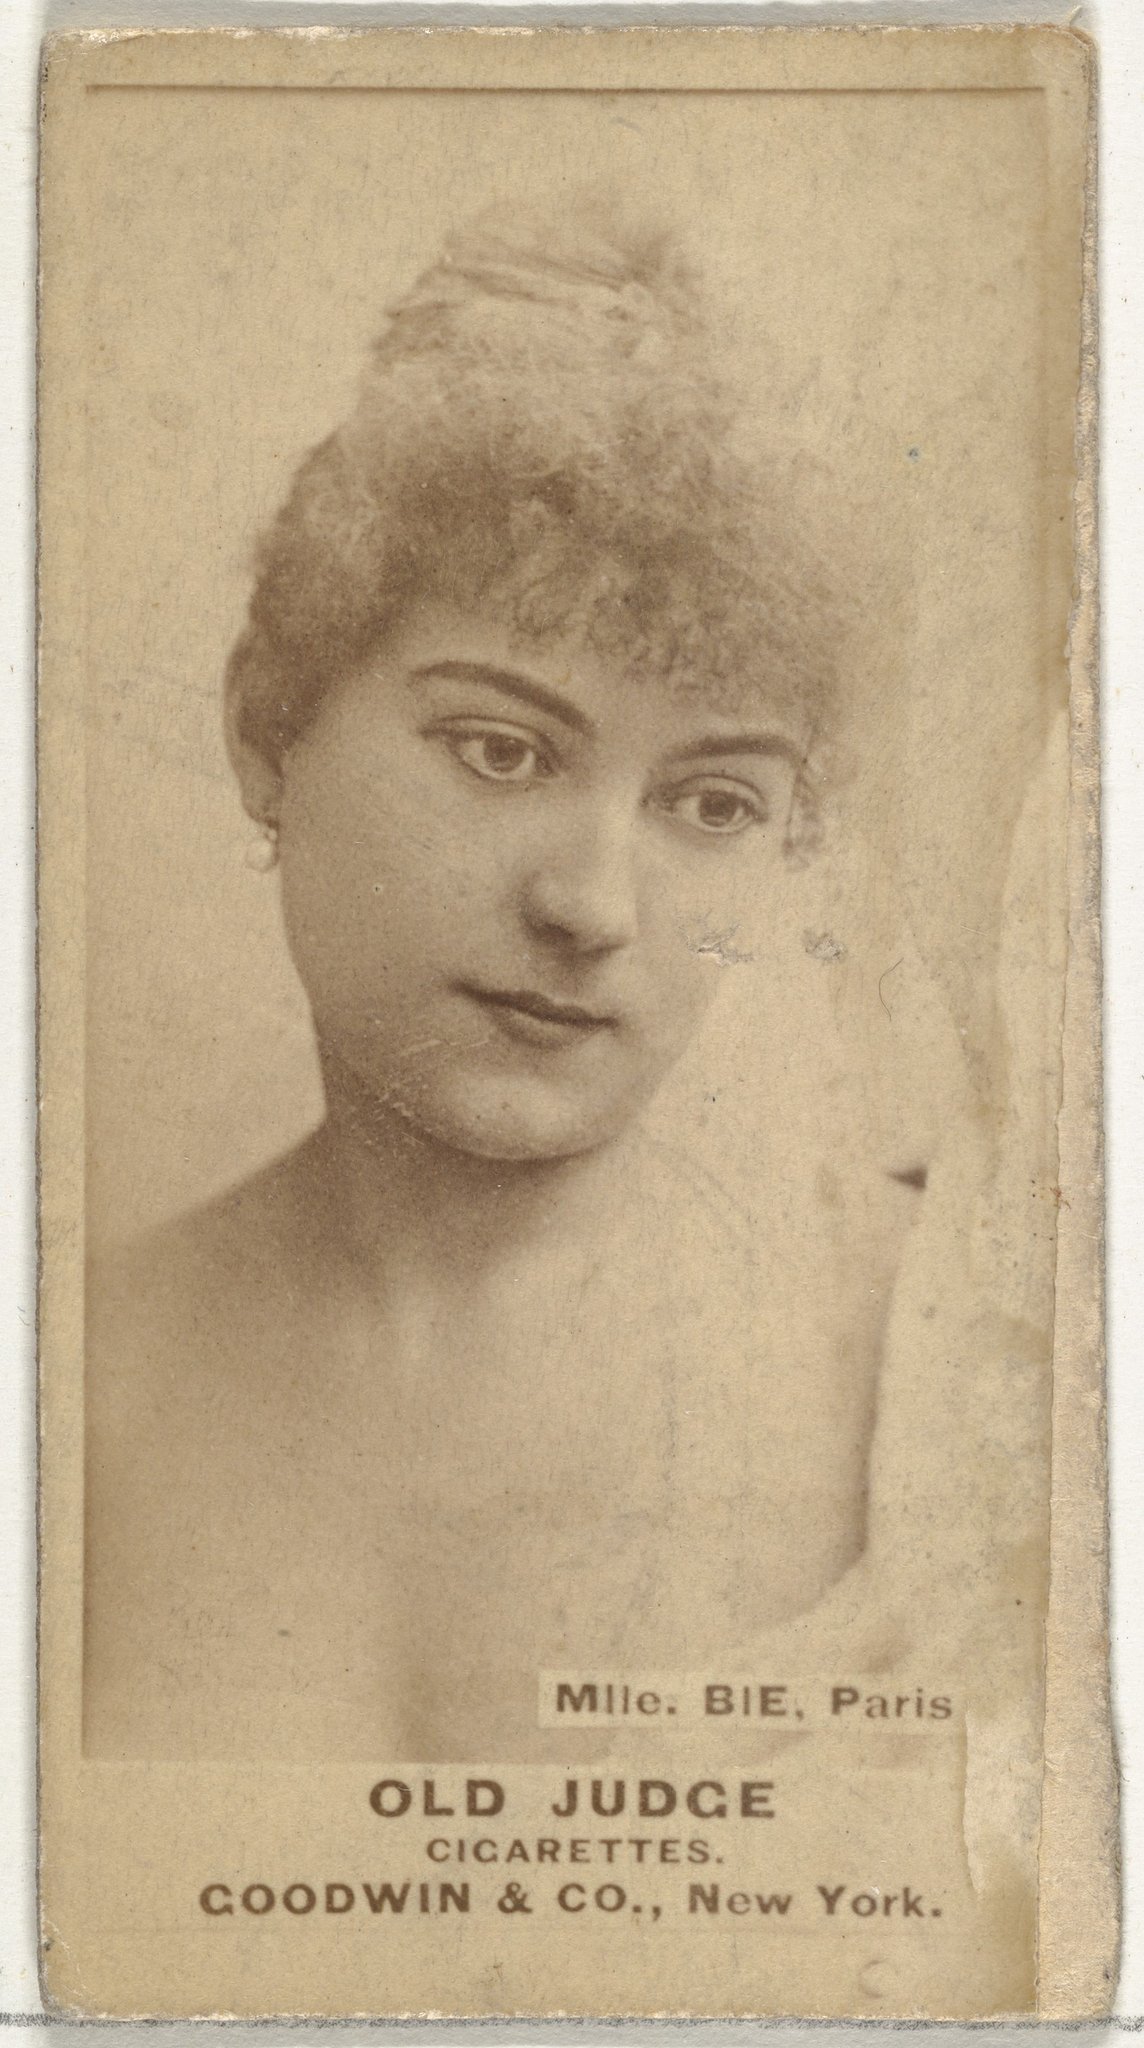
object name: photograph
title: Mlle. Bie, Paris, from the Actors and Actresses series (N171) for Old Judge Cigarettes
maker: goodwin & company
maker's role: publisher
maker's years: 1850-1950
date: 1886-1890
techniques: albumen silver print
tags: portraits,women,actresses